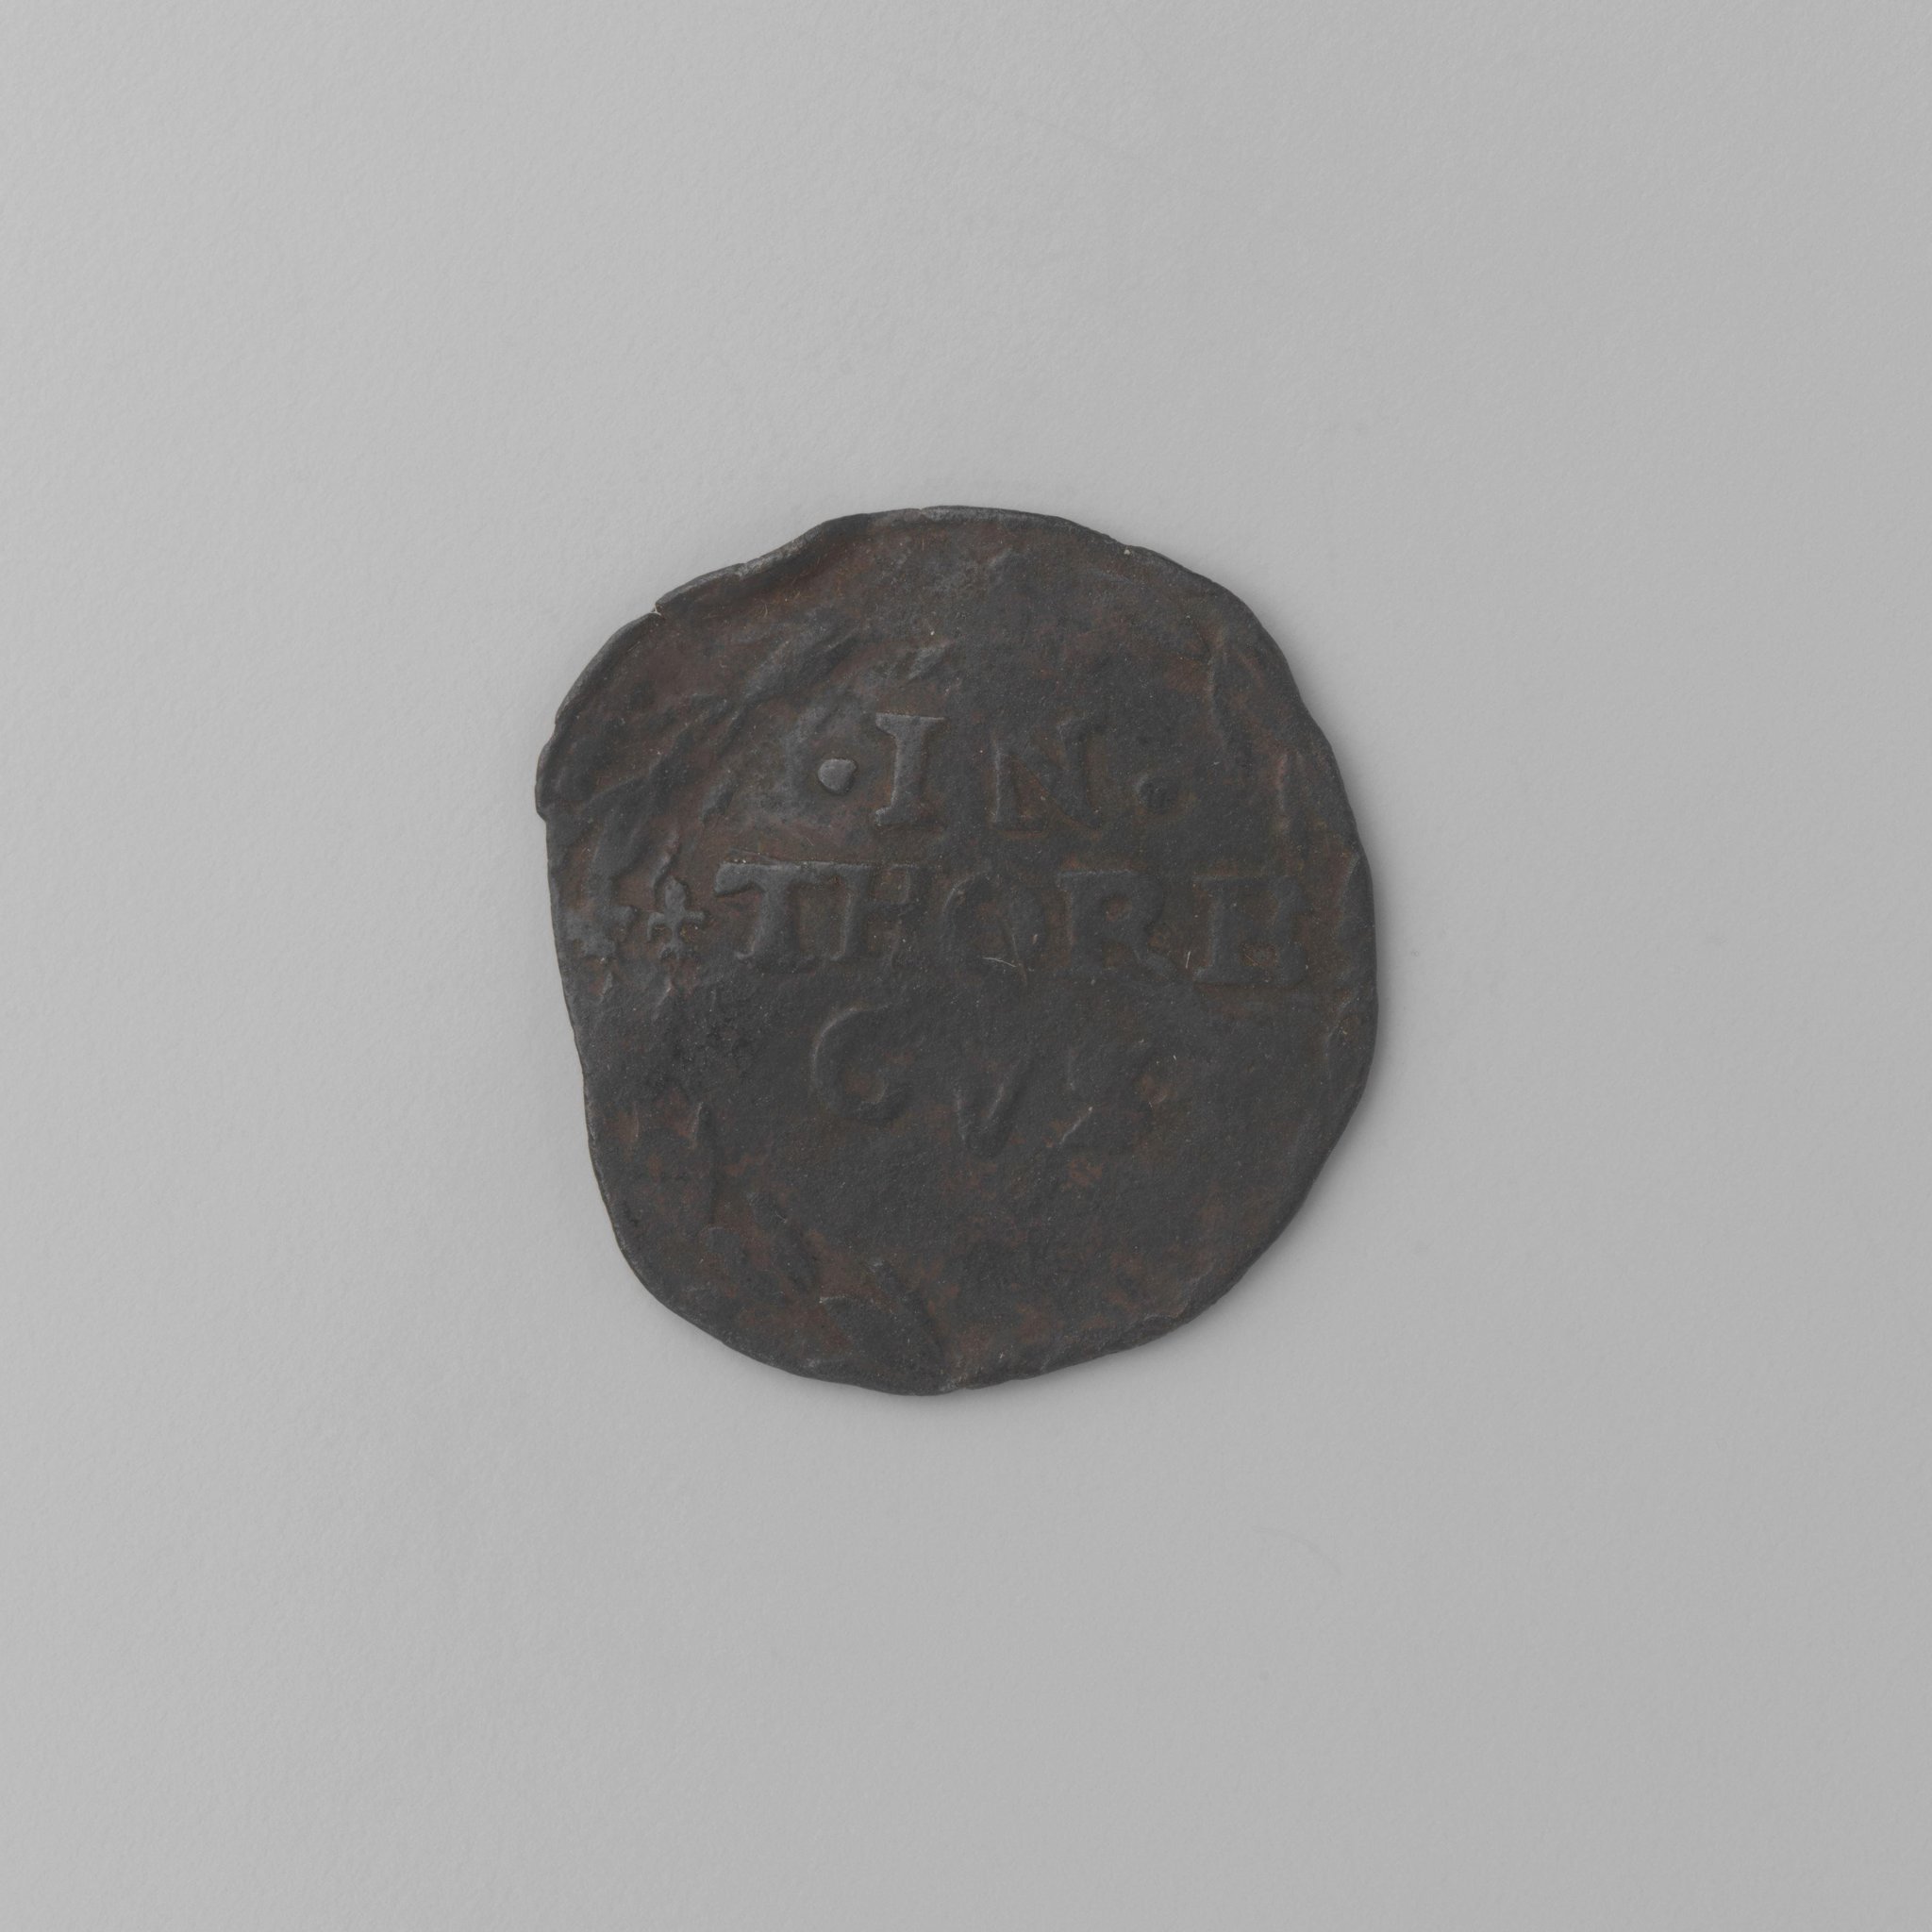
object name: coin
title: Duit van Anna van der Marck, abdis van Thorn, 1604-1631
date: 1604-1631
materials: copper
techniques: striking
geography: thorn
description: Koperen munt. Voorzijde: binnen lauwerkrans gekroond wapenschild. Keerzijde: binnen lauwerkrans drie-regelig opschrift.